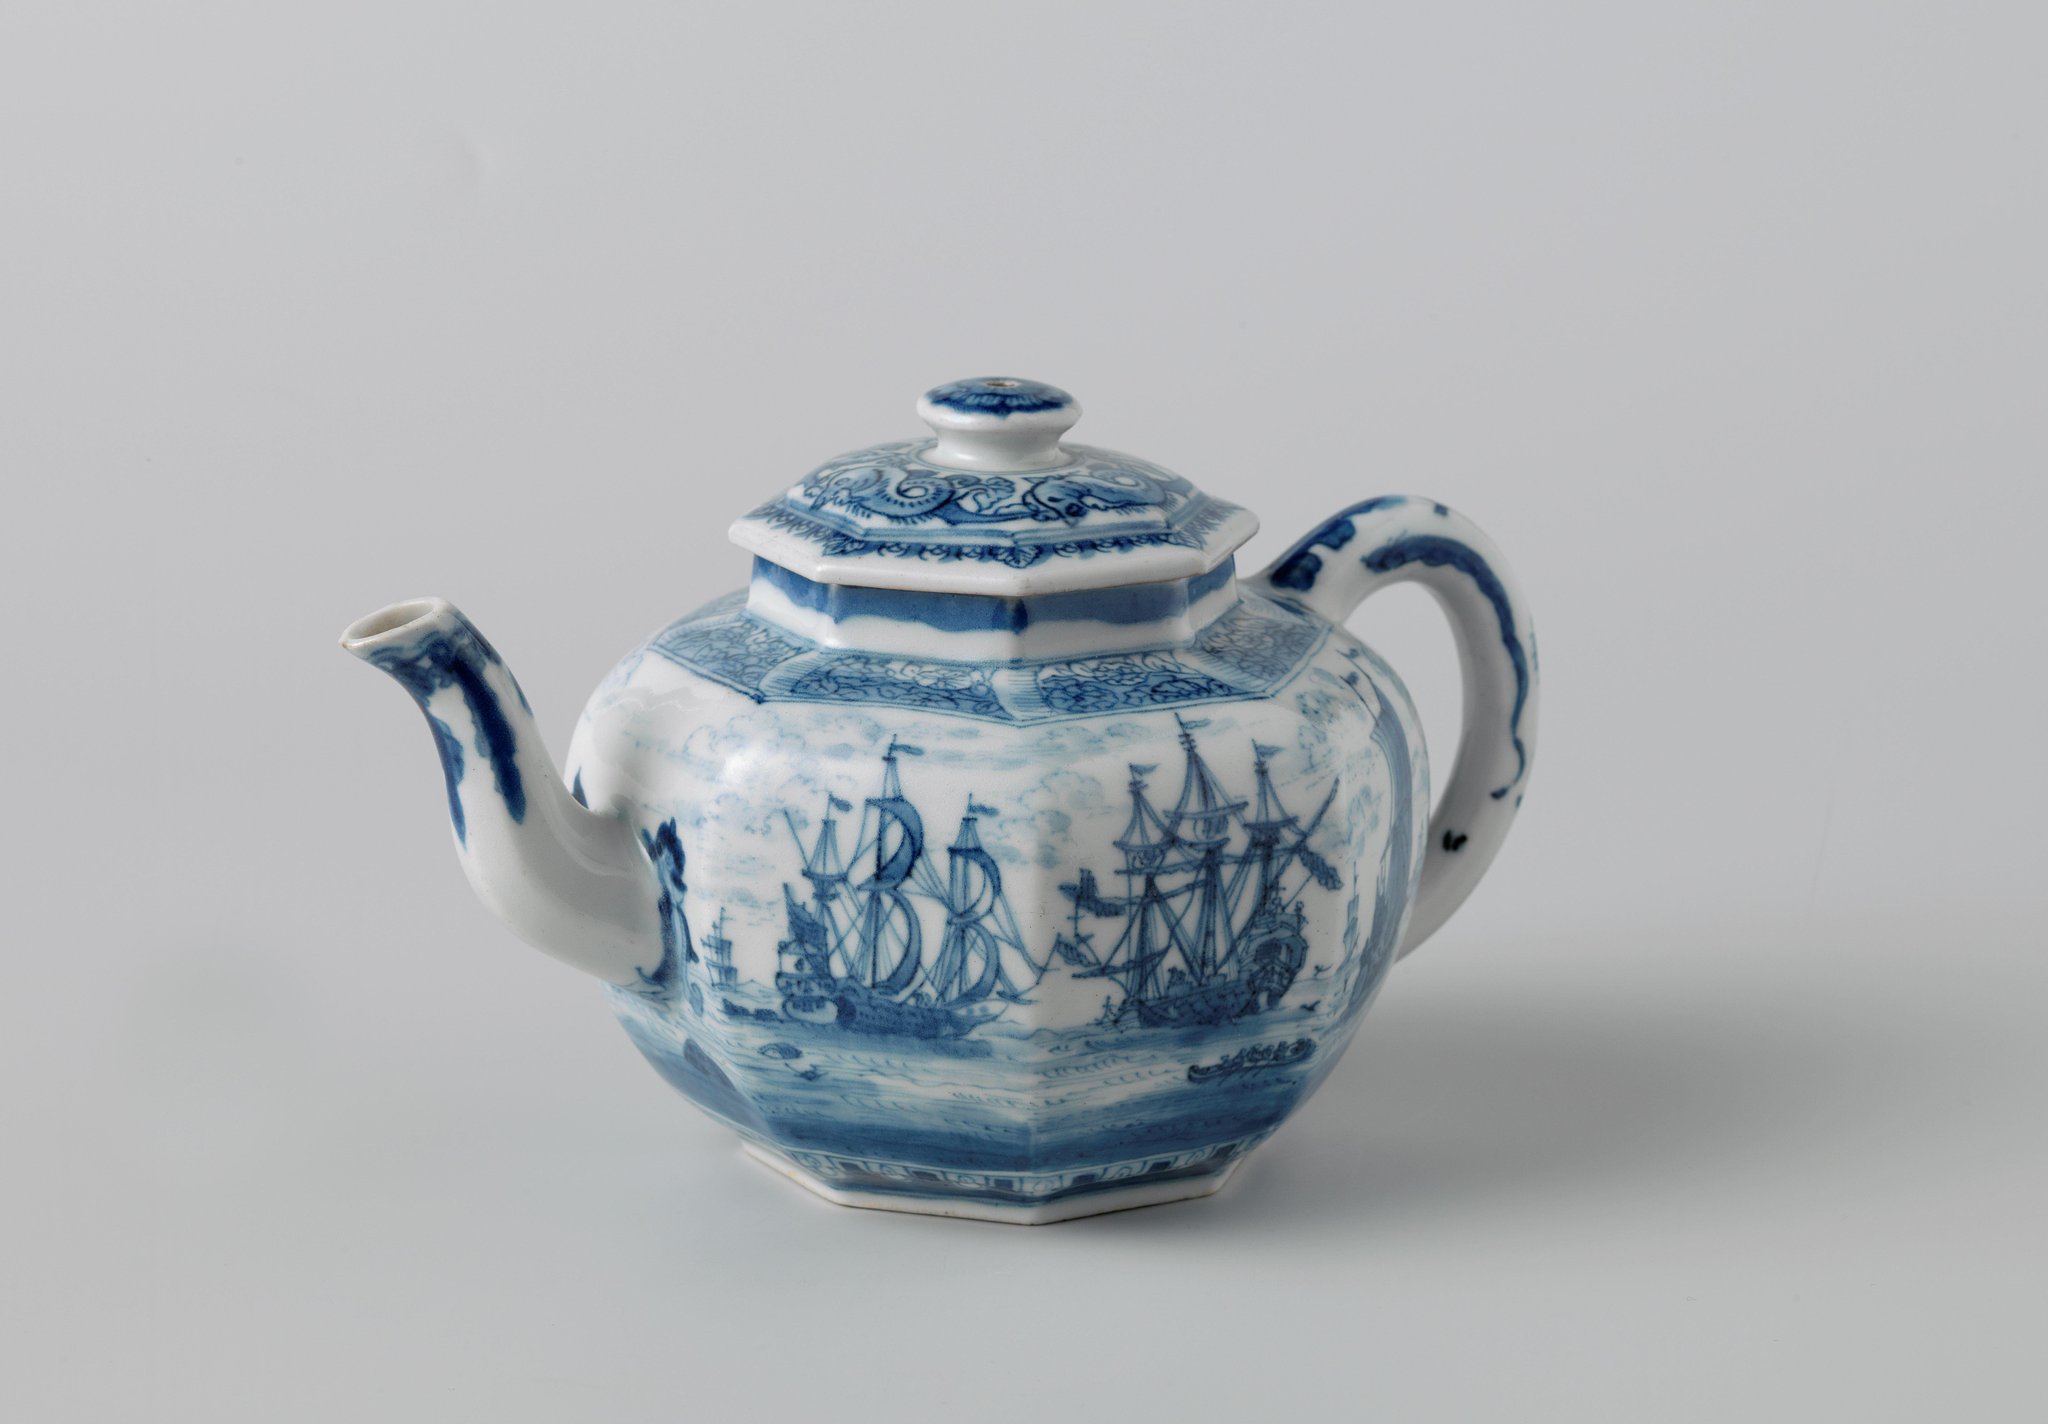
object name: teapot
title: Octagonal teapot with a seascape with European ships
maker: Anonymous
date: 1725-1749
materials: cobalt, glaze, paint, porcelain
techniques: firing, forming, turning, vitrification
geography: japan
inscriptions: mark: ‘大 明 成 化 年 製’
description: Achthoekige theepot van porselein met een S-vormige tuit en C-vormig oor, beschilderd in onderglazuur blauw. Op de buik een zeegezicht met Europese schepen. Boven de voet een decoratieve band. Op de schouder een band met acht vakken met bloemranken. De tuit en de schouder met bloemranken en wolkmotieven. Gemerkt op de onderzijde met het zes-karaktermerk van keizer Chenghua. Blauw-wit.